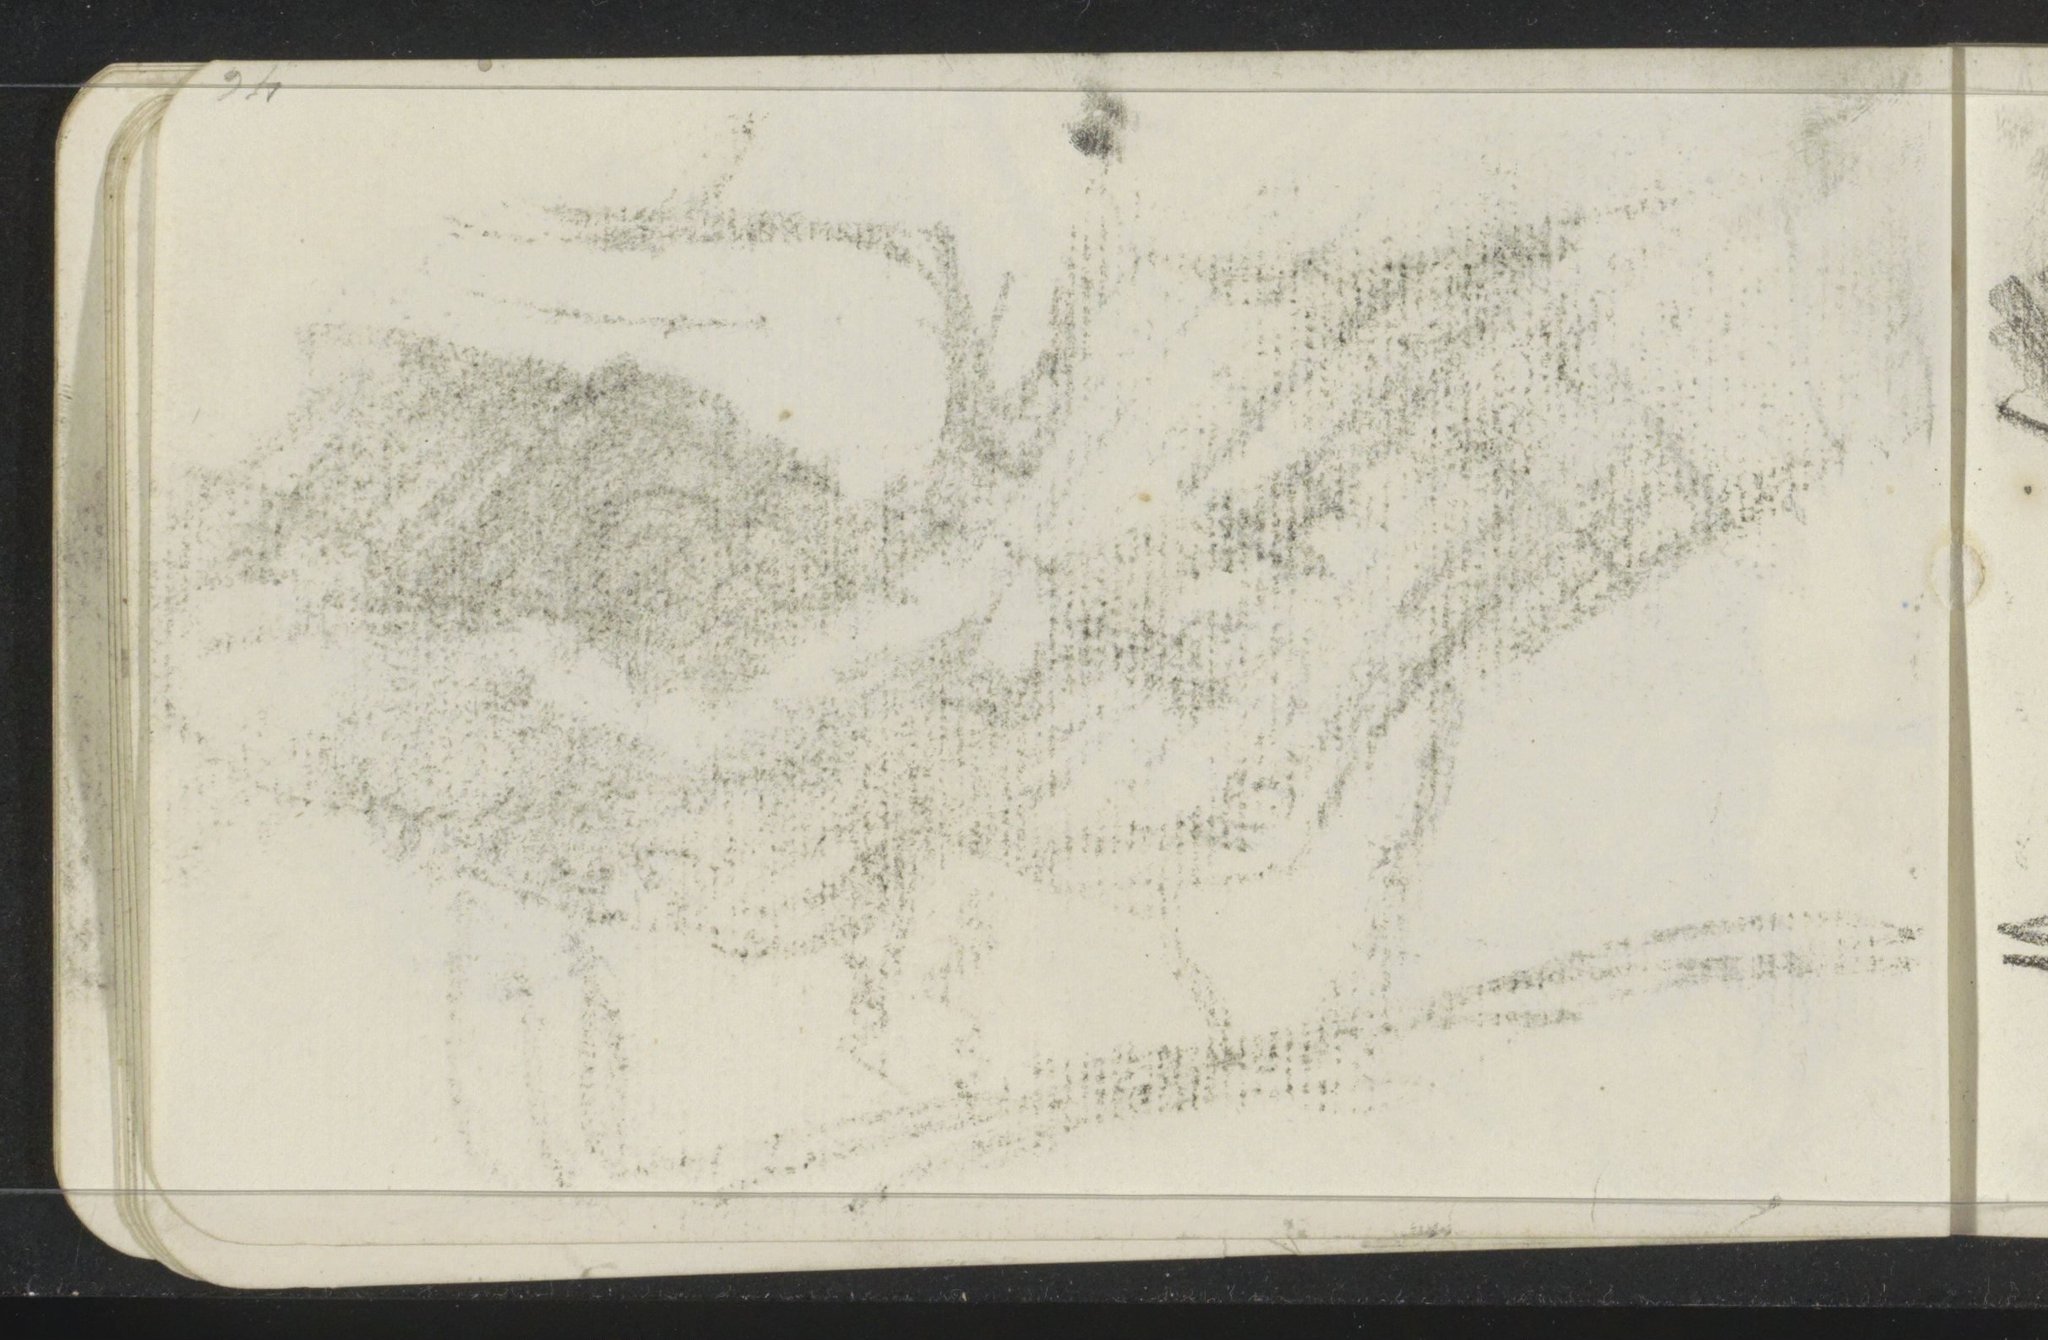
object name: sketchbook leaf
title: Abklatsch van de krijttekening op blad 12 recto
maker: isaac israels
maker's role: draughtsman, painter, print maker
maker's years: 1865-1934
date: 1875-1934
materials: paper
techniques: printmaking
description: Blad 11 verso uit schetsboek LXII met 28 bladen.